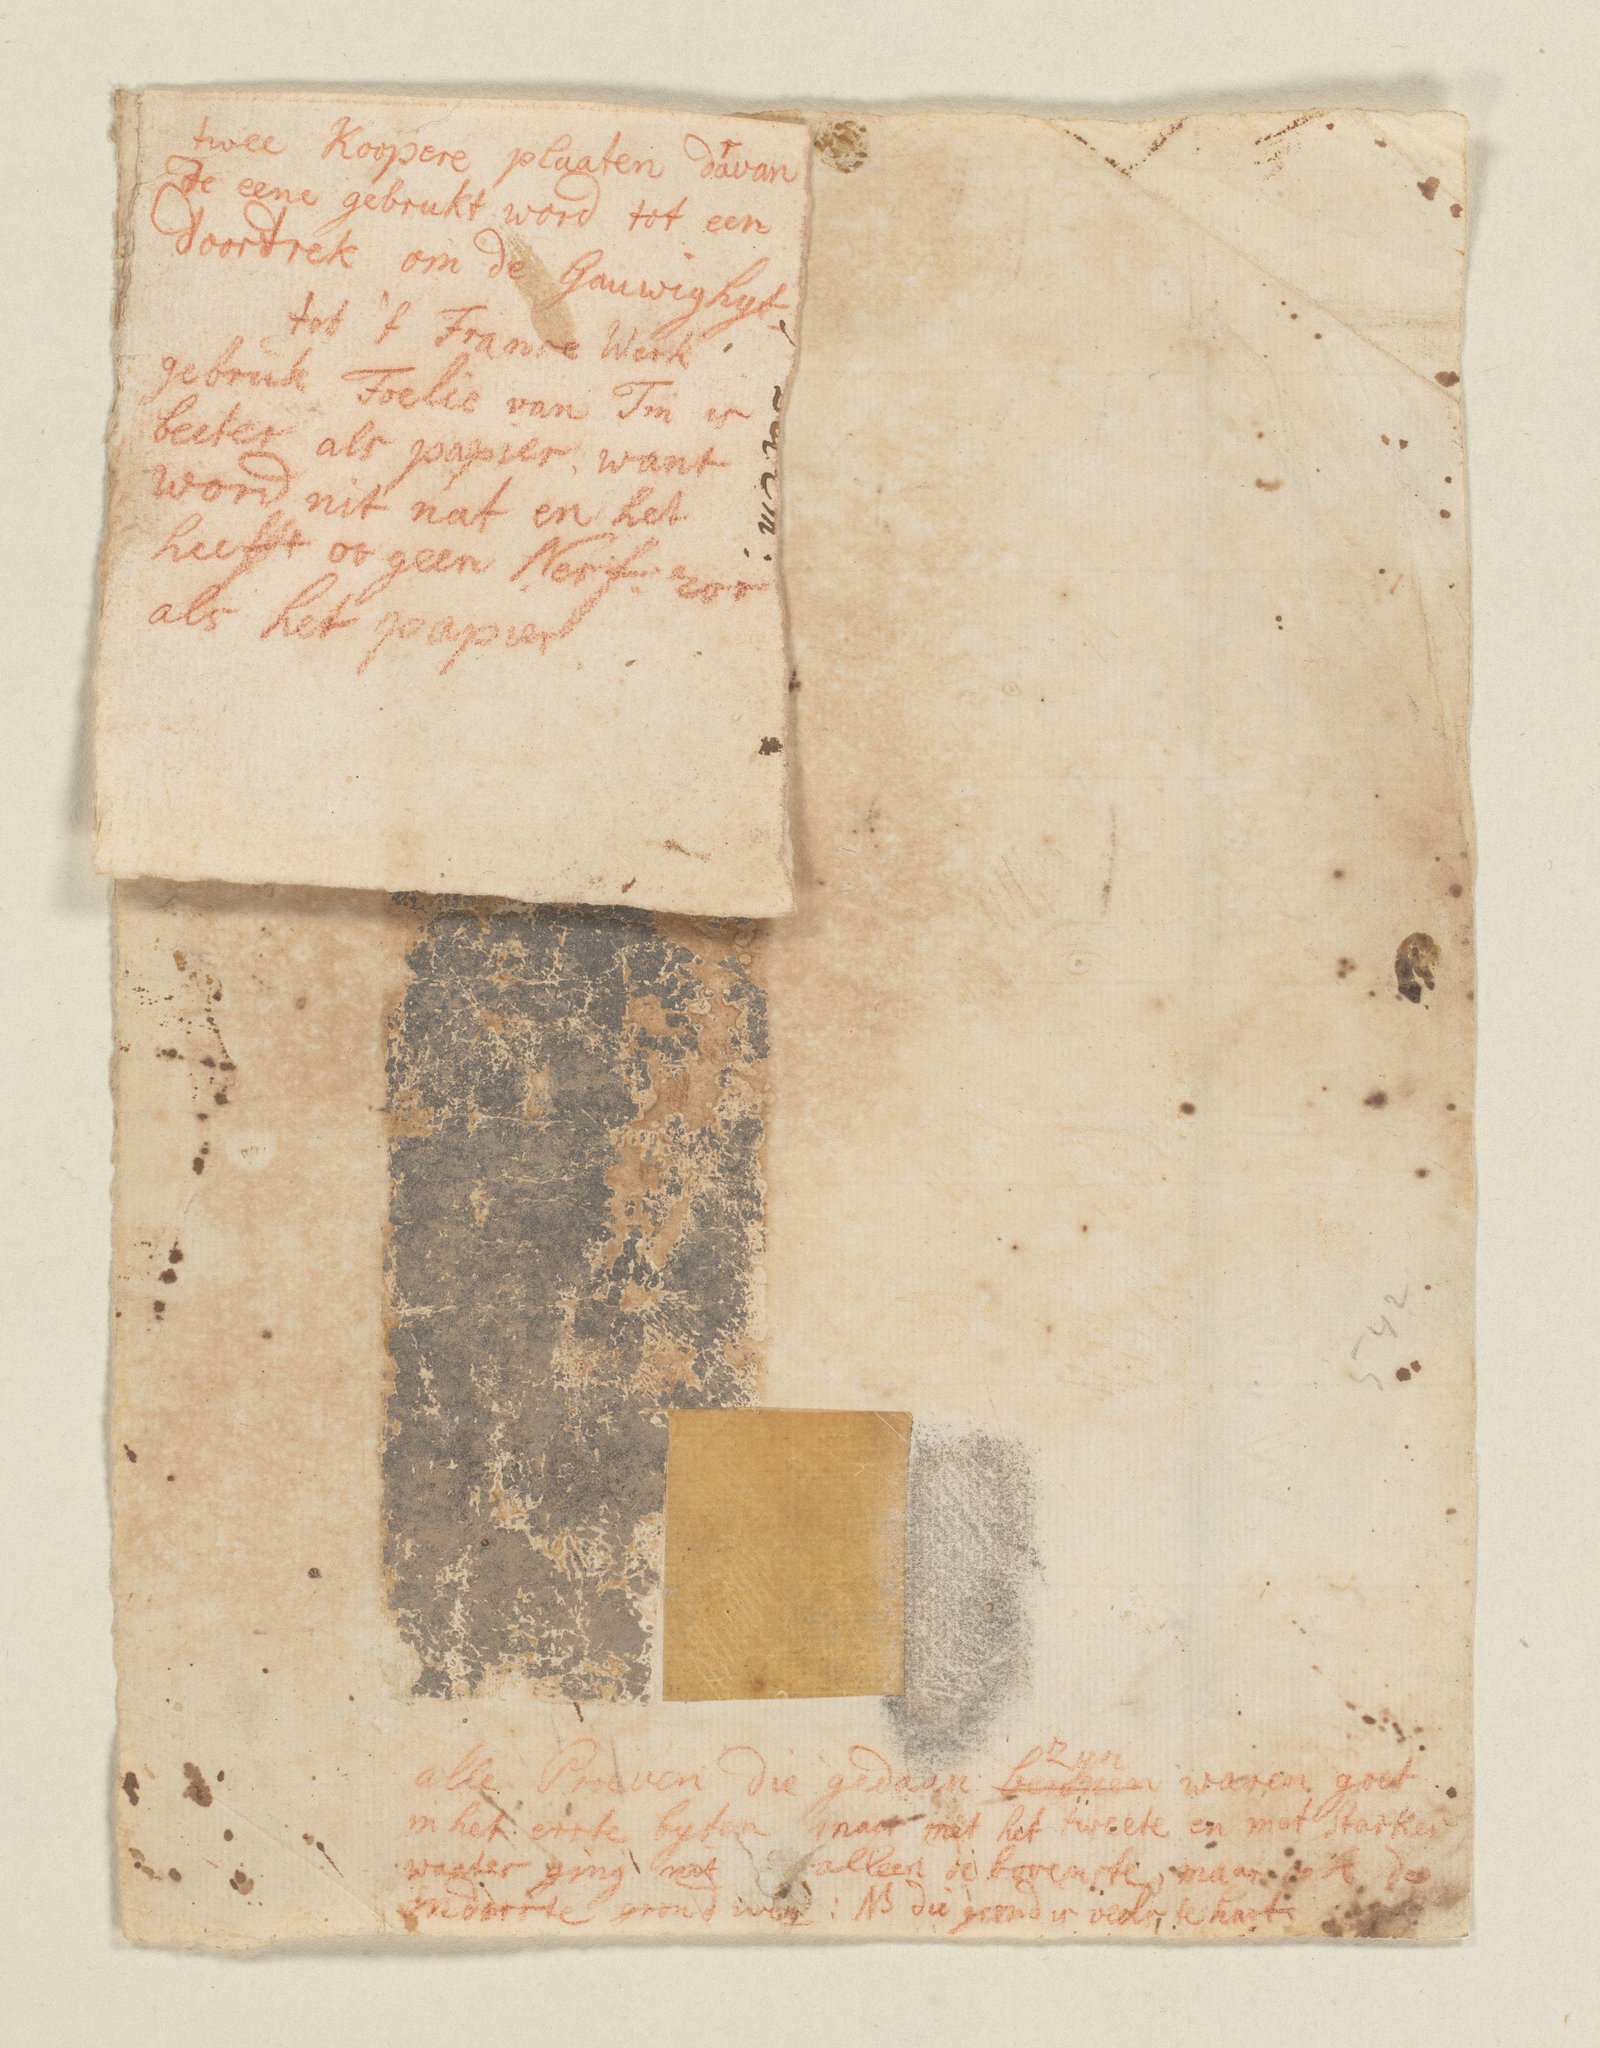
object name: print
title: Proef van grafische techniek met verklarende tekst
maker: cornelis ploos van amstel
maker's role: draughtsman, print maker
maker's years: 1726-1798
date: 1736-1798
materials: chalk, paper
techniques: blind stamped, writing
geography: amsterdam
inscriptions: inscription: ‘alle Proeven die gedaan zyn waren goet/ in het erste byten maar met het tweede en met starker/ waater ging nit alleen de bovenste maar ook de/ onderste grond weg: ... die grond is veel te nats/hart(?)’, inscription: ‘twee koperen plaaten darvan/ de eene gebrukt word tot een/ doortrek om de gauwighyt/ tot 't Franse Werk/ gebruik Foelie van Tin is/ beeter als papier, want/ word nit nat en het heeft oc(?) geen Nerf, zoo/als het papier’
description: De prent en tekst liggen los achterin een album.